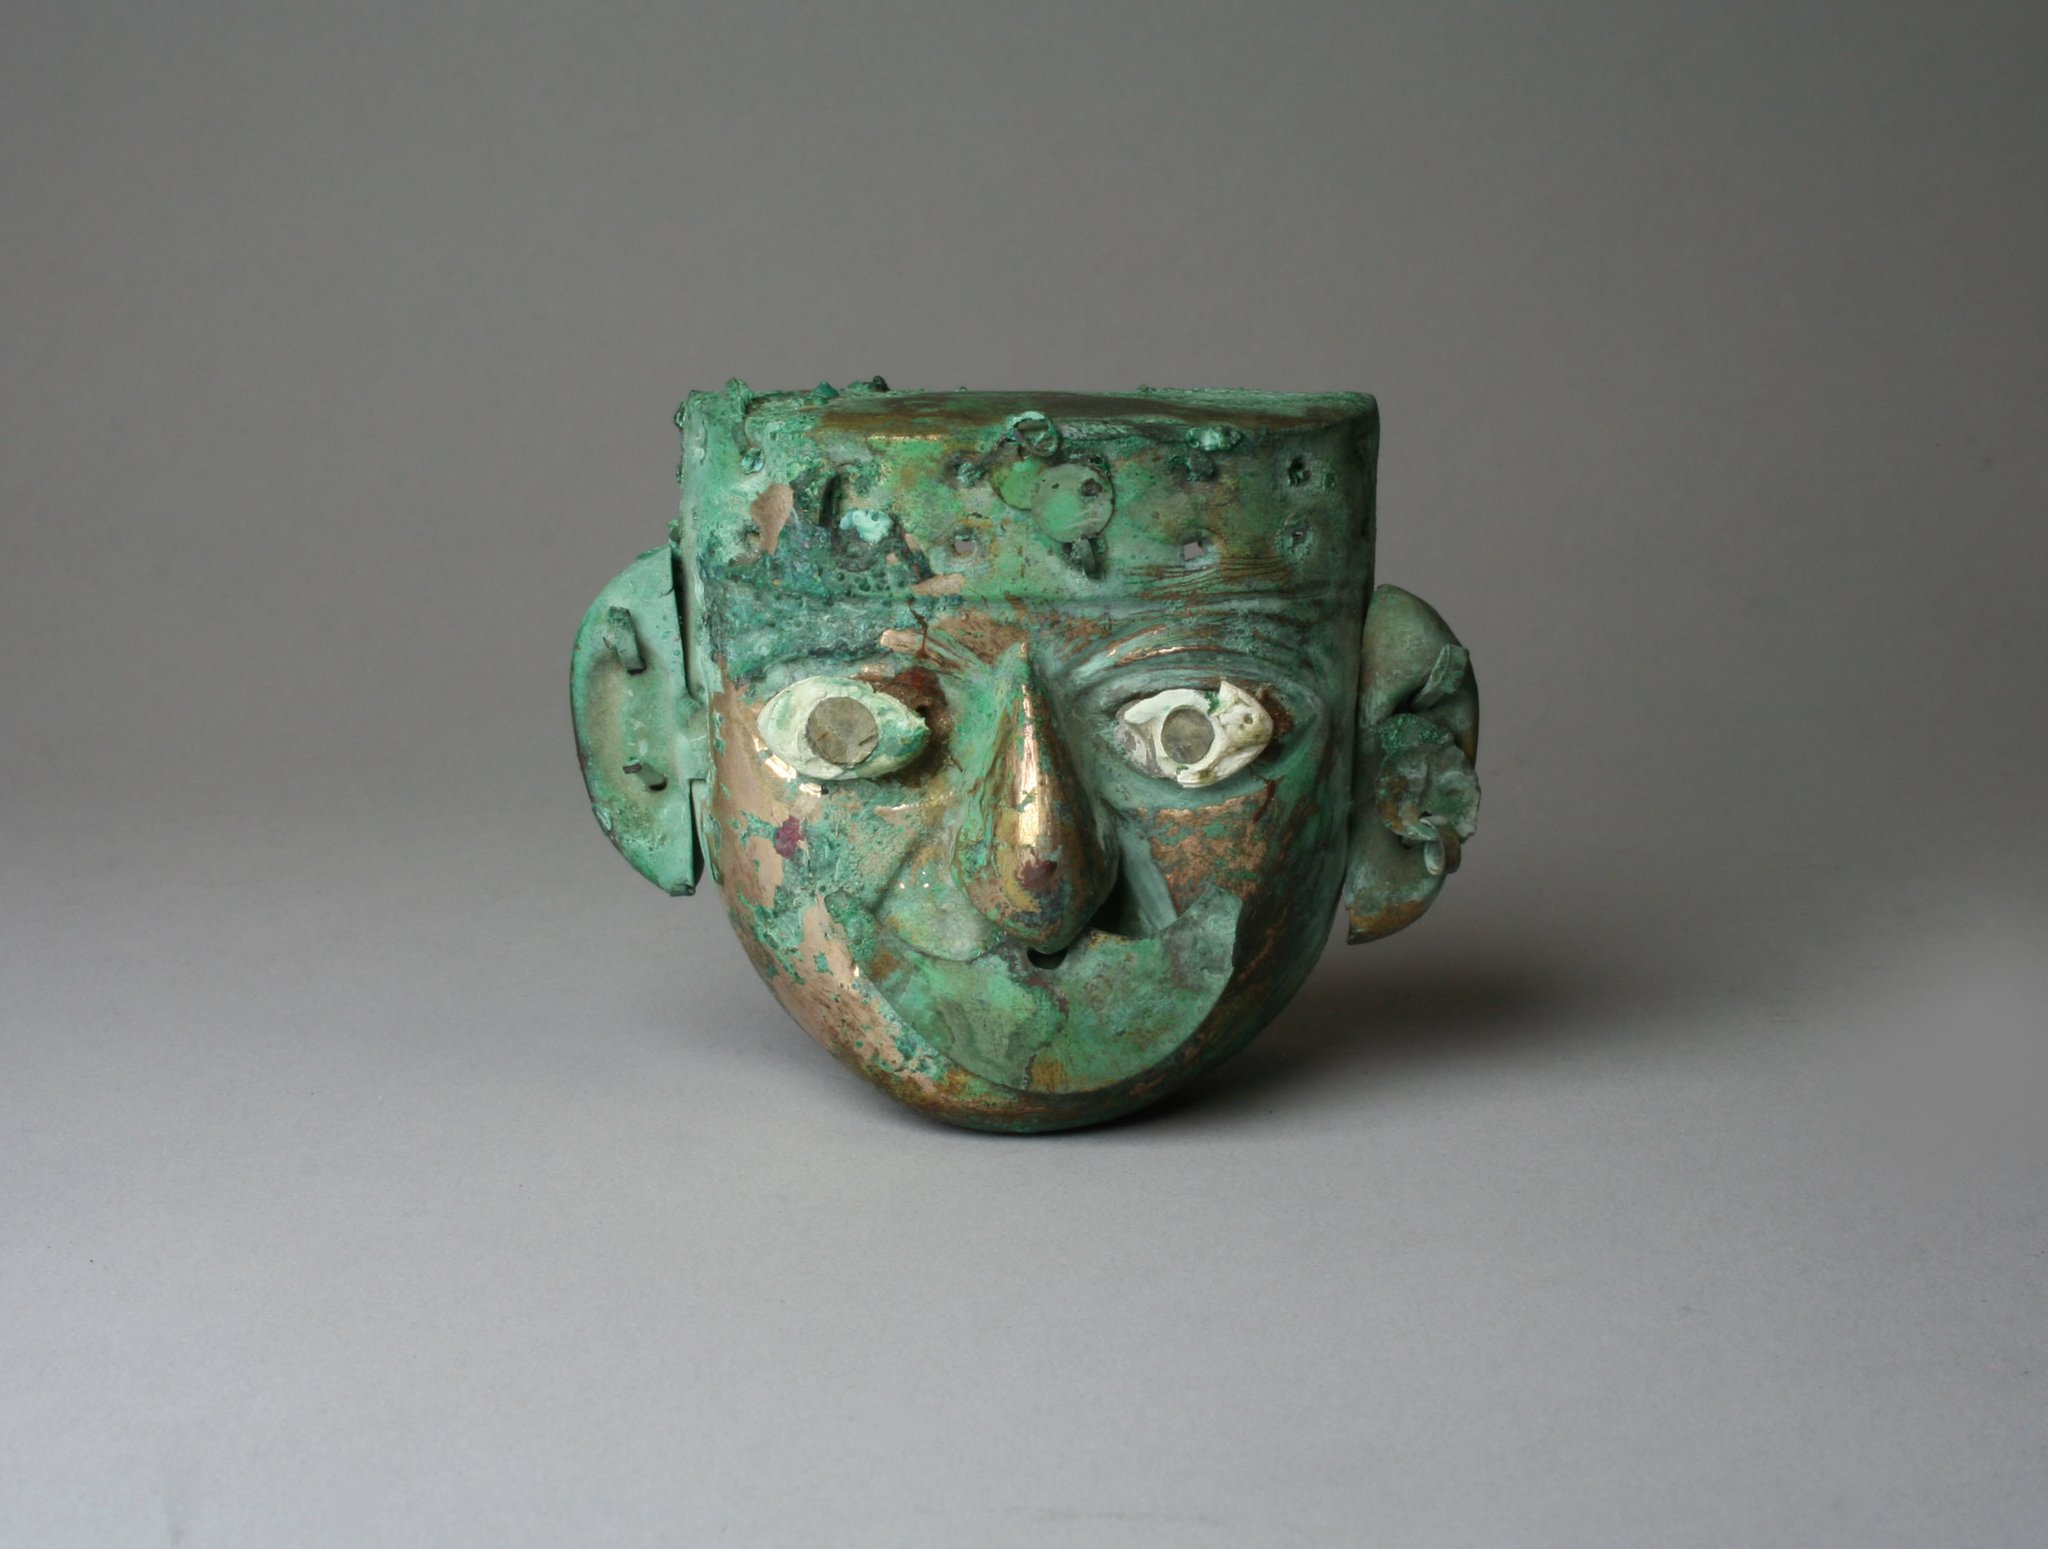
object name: ornament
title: Face Mask Ornament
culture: moche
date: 501-700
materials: gilt copper, shell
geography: peru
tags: faces